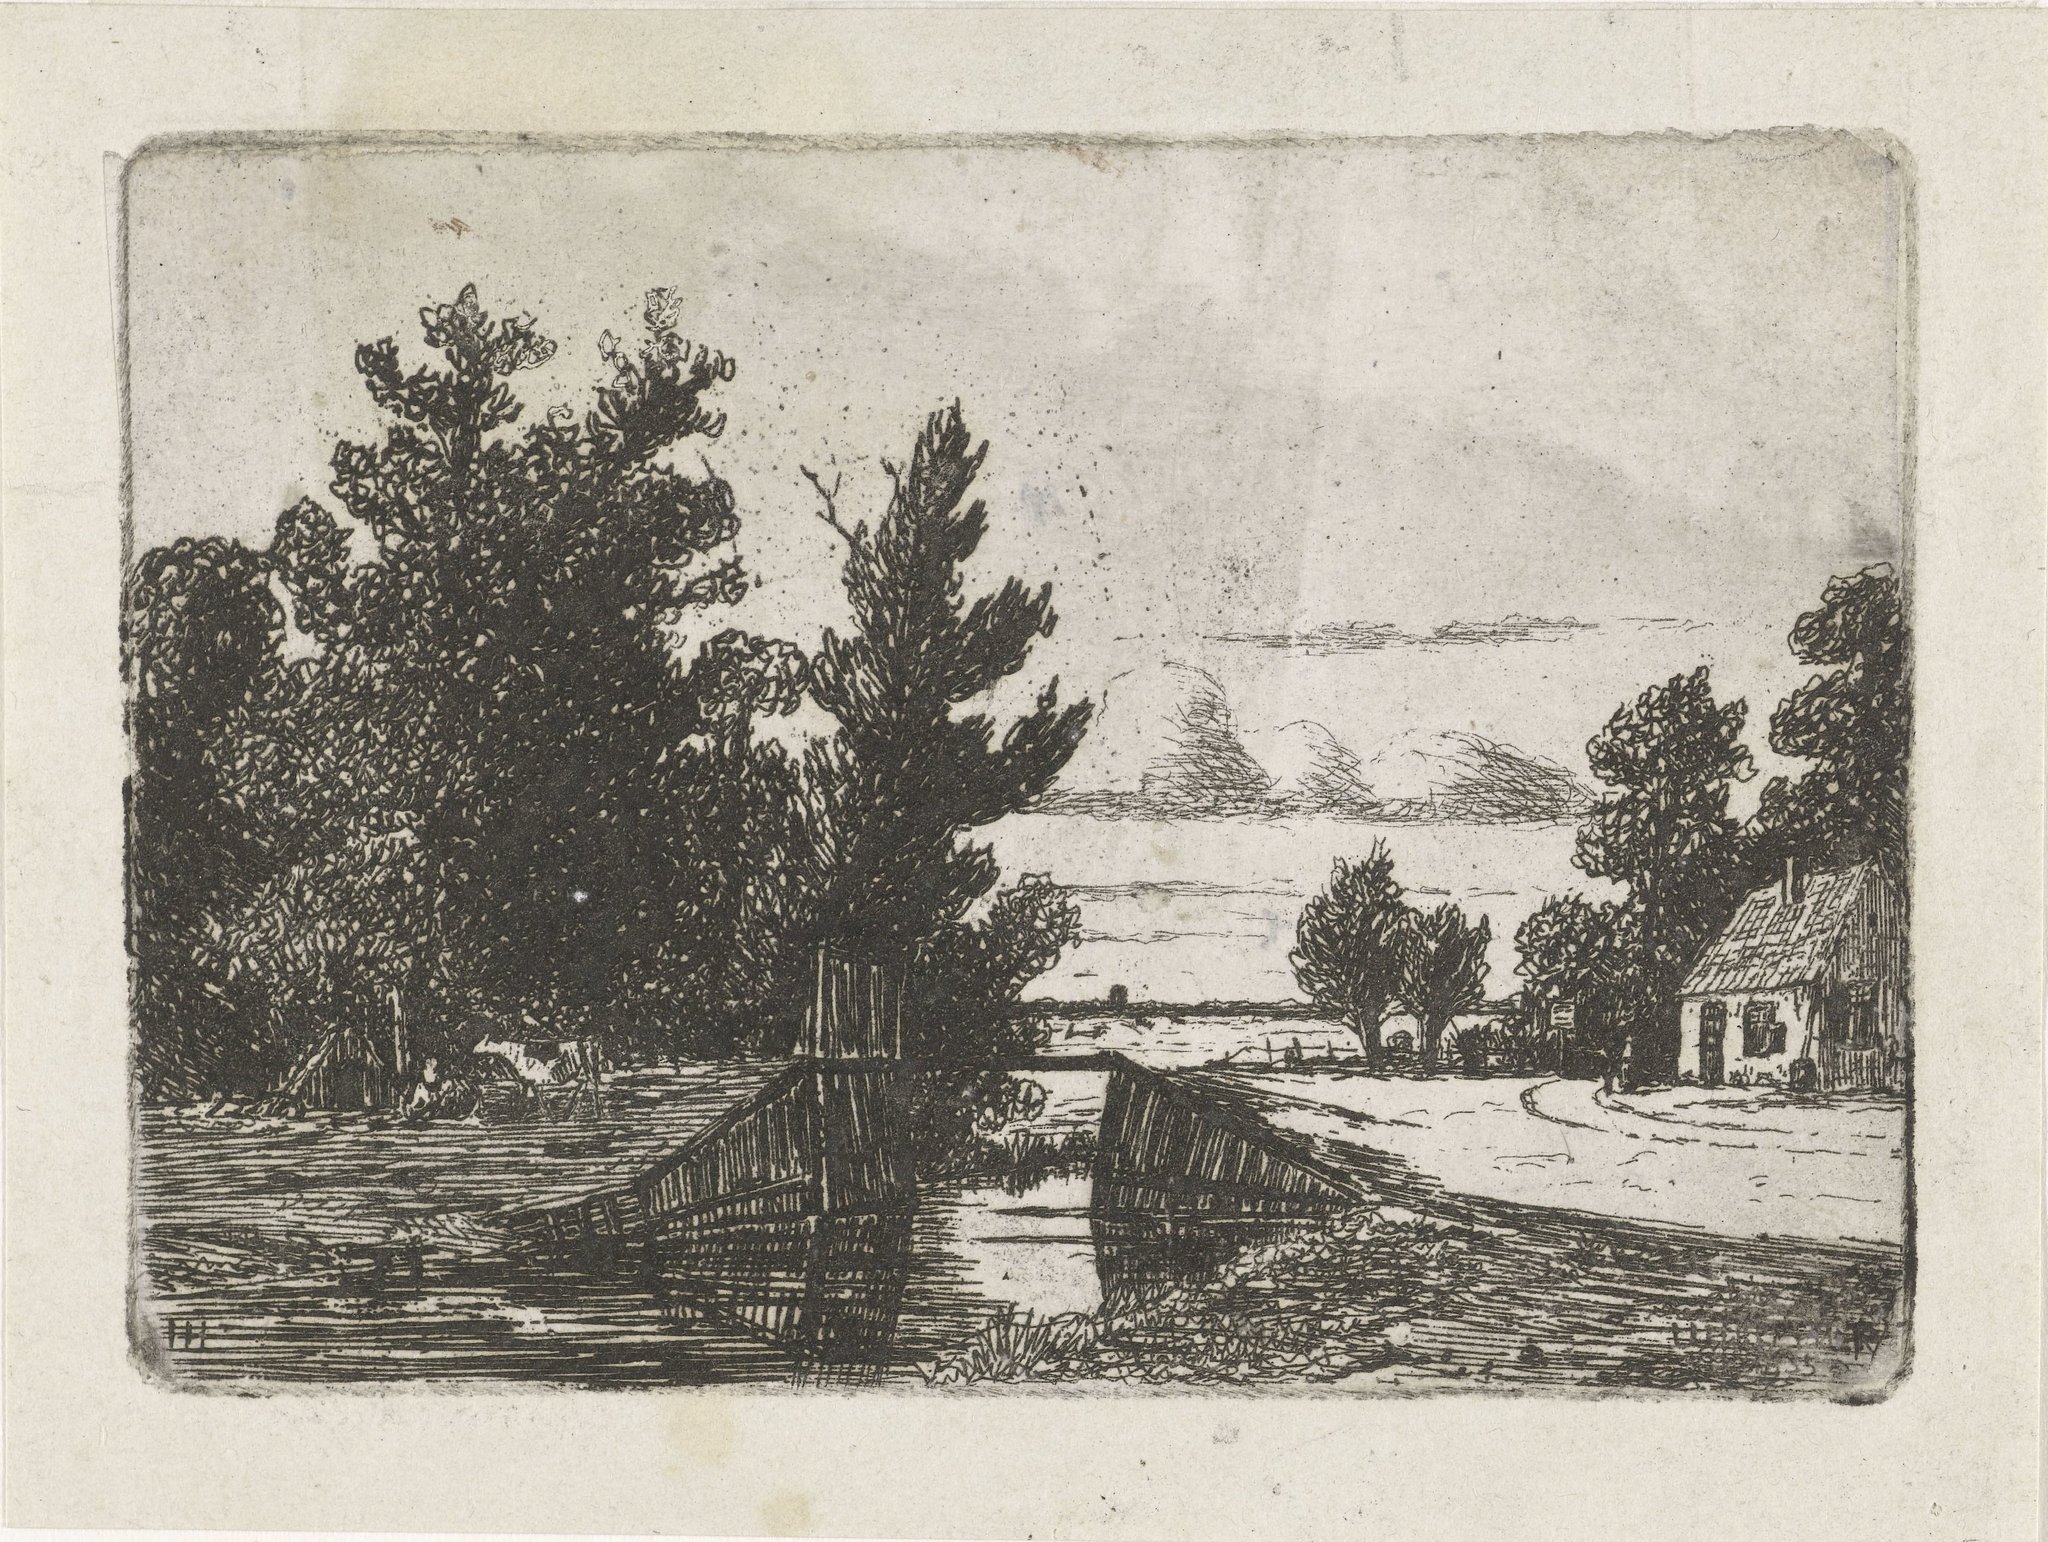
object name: print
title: Landschap met bruggetje over een sloot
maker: jan heppener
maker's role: print maker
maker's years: 1826-1898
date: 1841-1898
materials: paper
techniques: drypoint, etching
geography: the hague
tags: landscape with bridge, viaduct or aqueduct, farm or solitary house in landscape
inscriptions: collector's mark: Lugt 2228